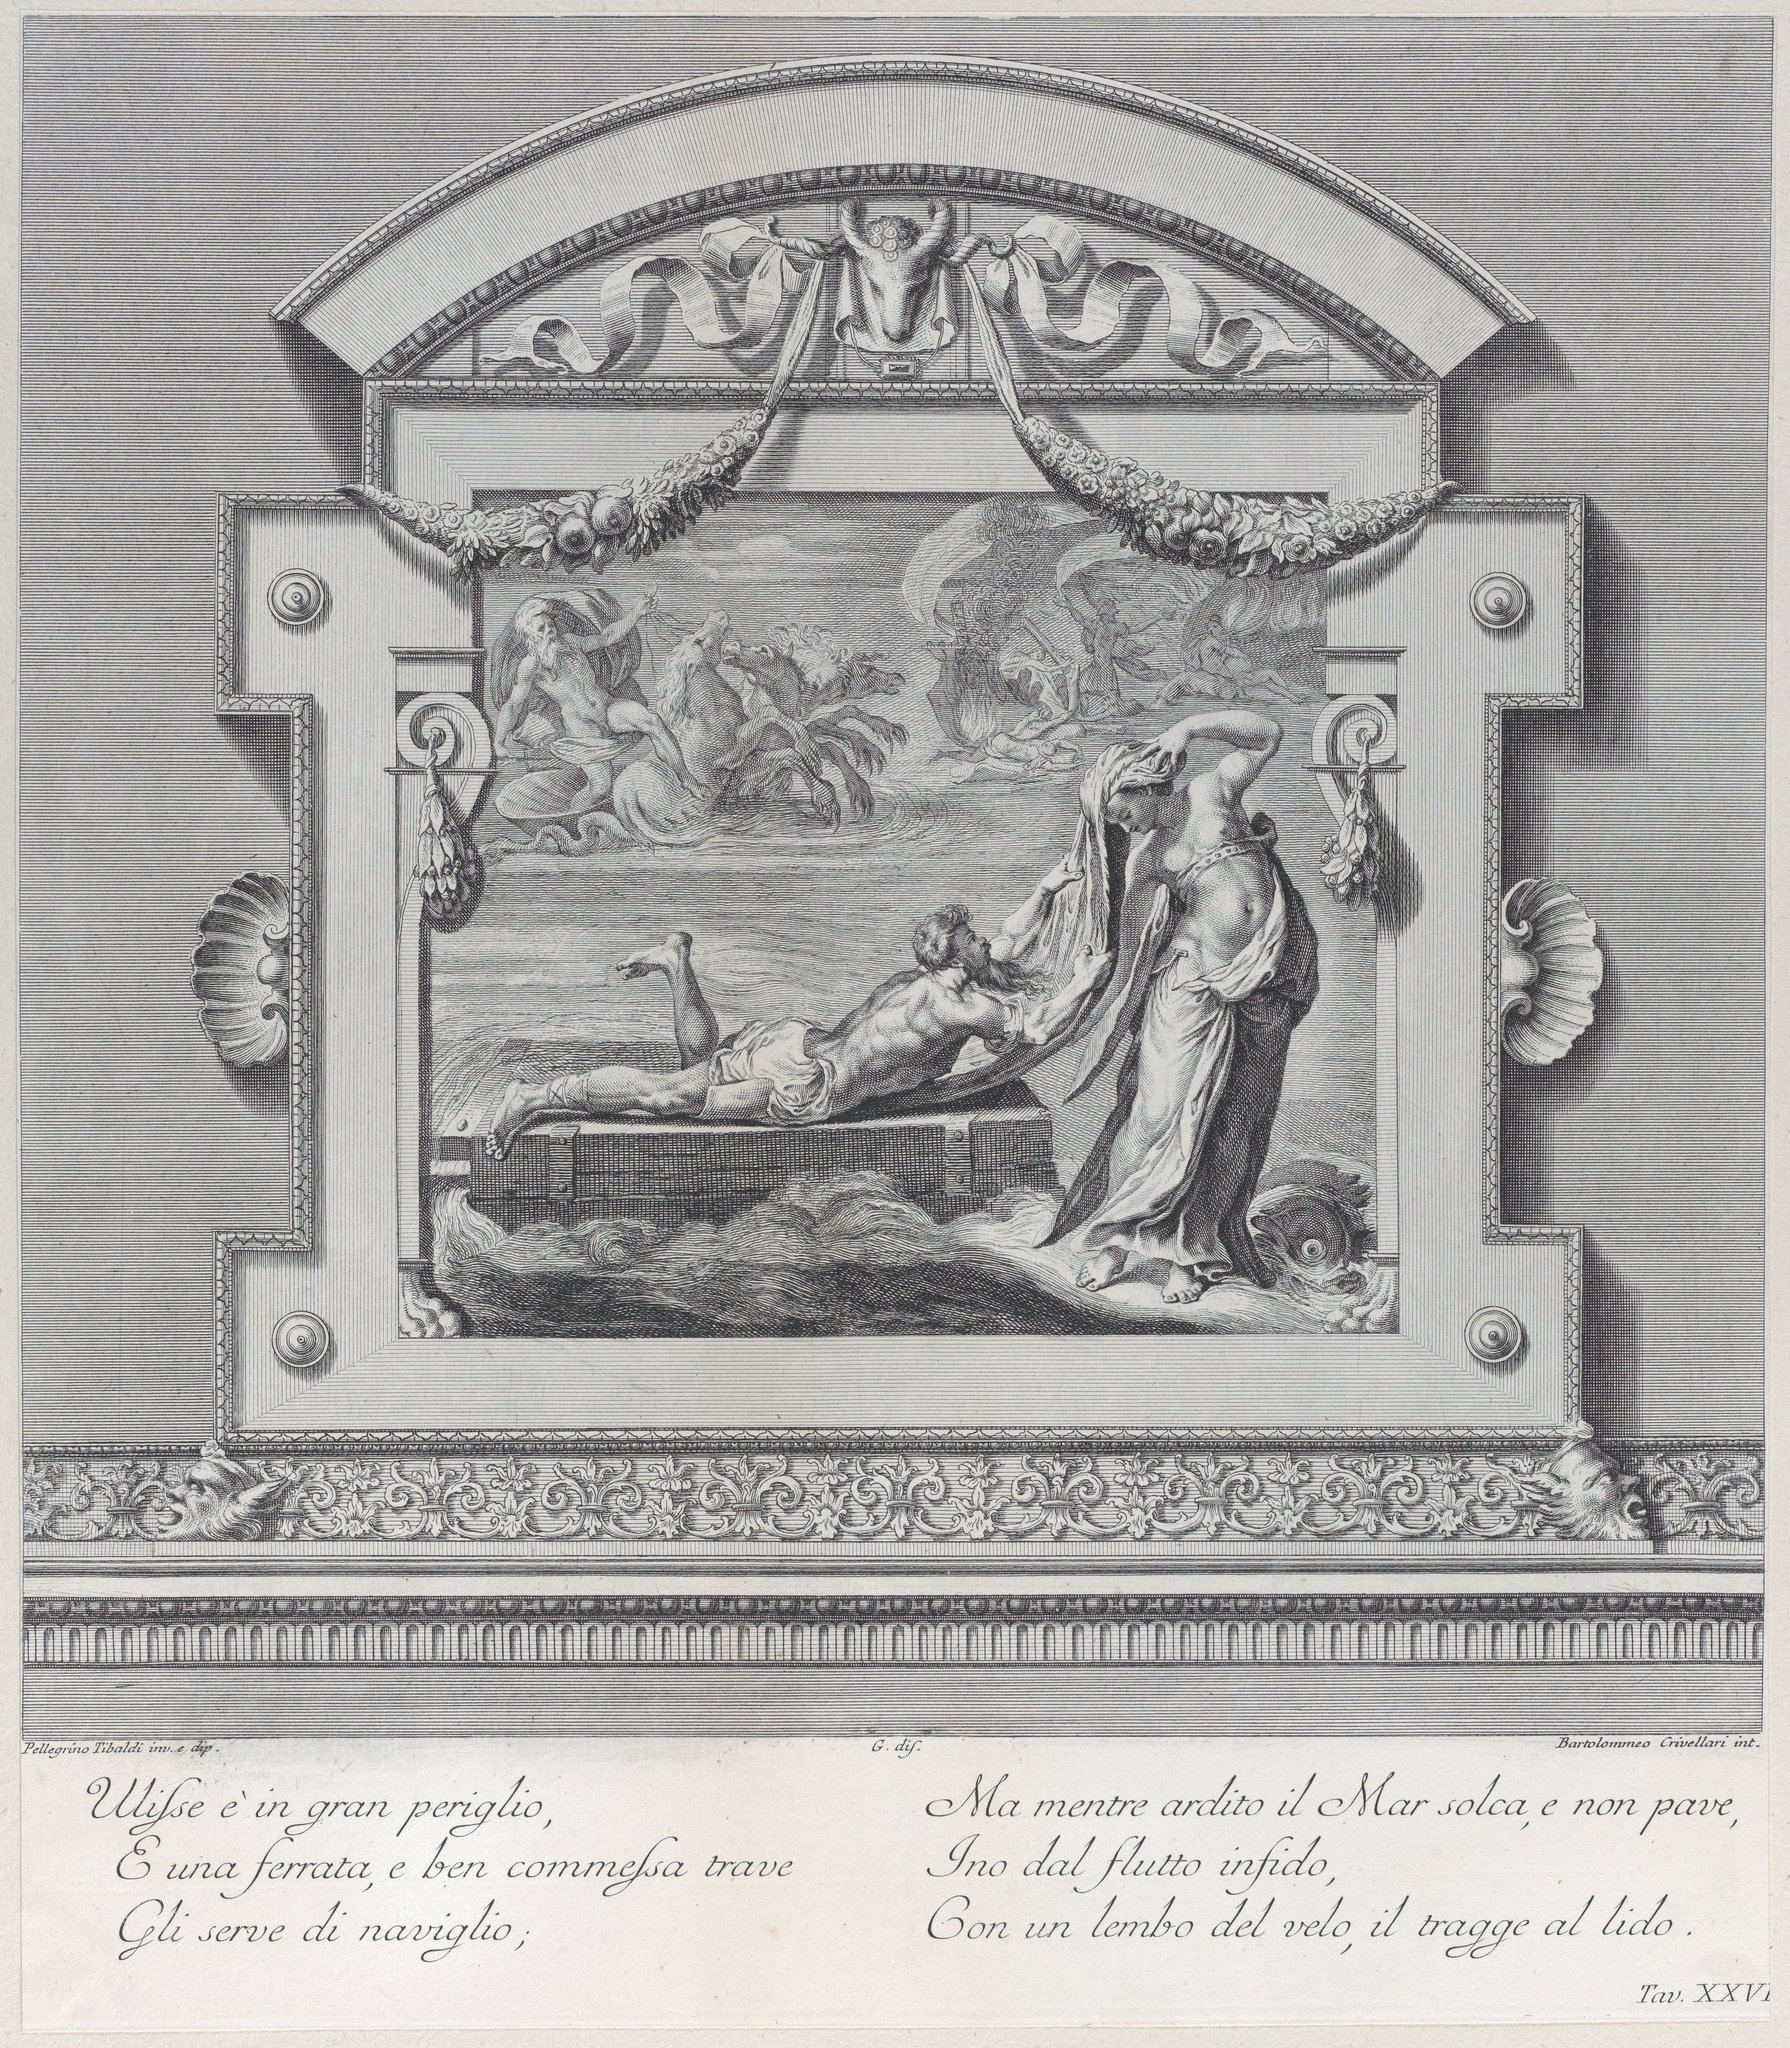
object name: print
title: Plate 26: Ulysses escaping on a raft with the aid of the sea deity Leucothea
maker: bartolomeo crivellari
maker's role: artist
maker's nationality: italian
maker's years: 1700-1800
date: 1756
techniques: engraving, etching